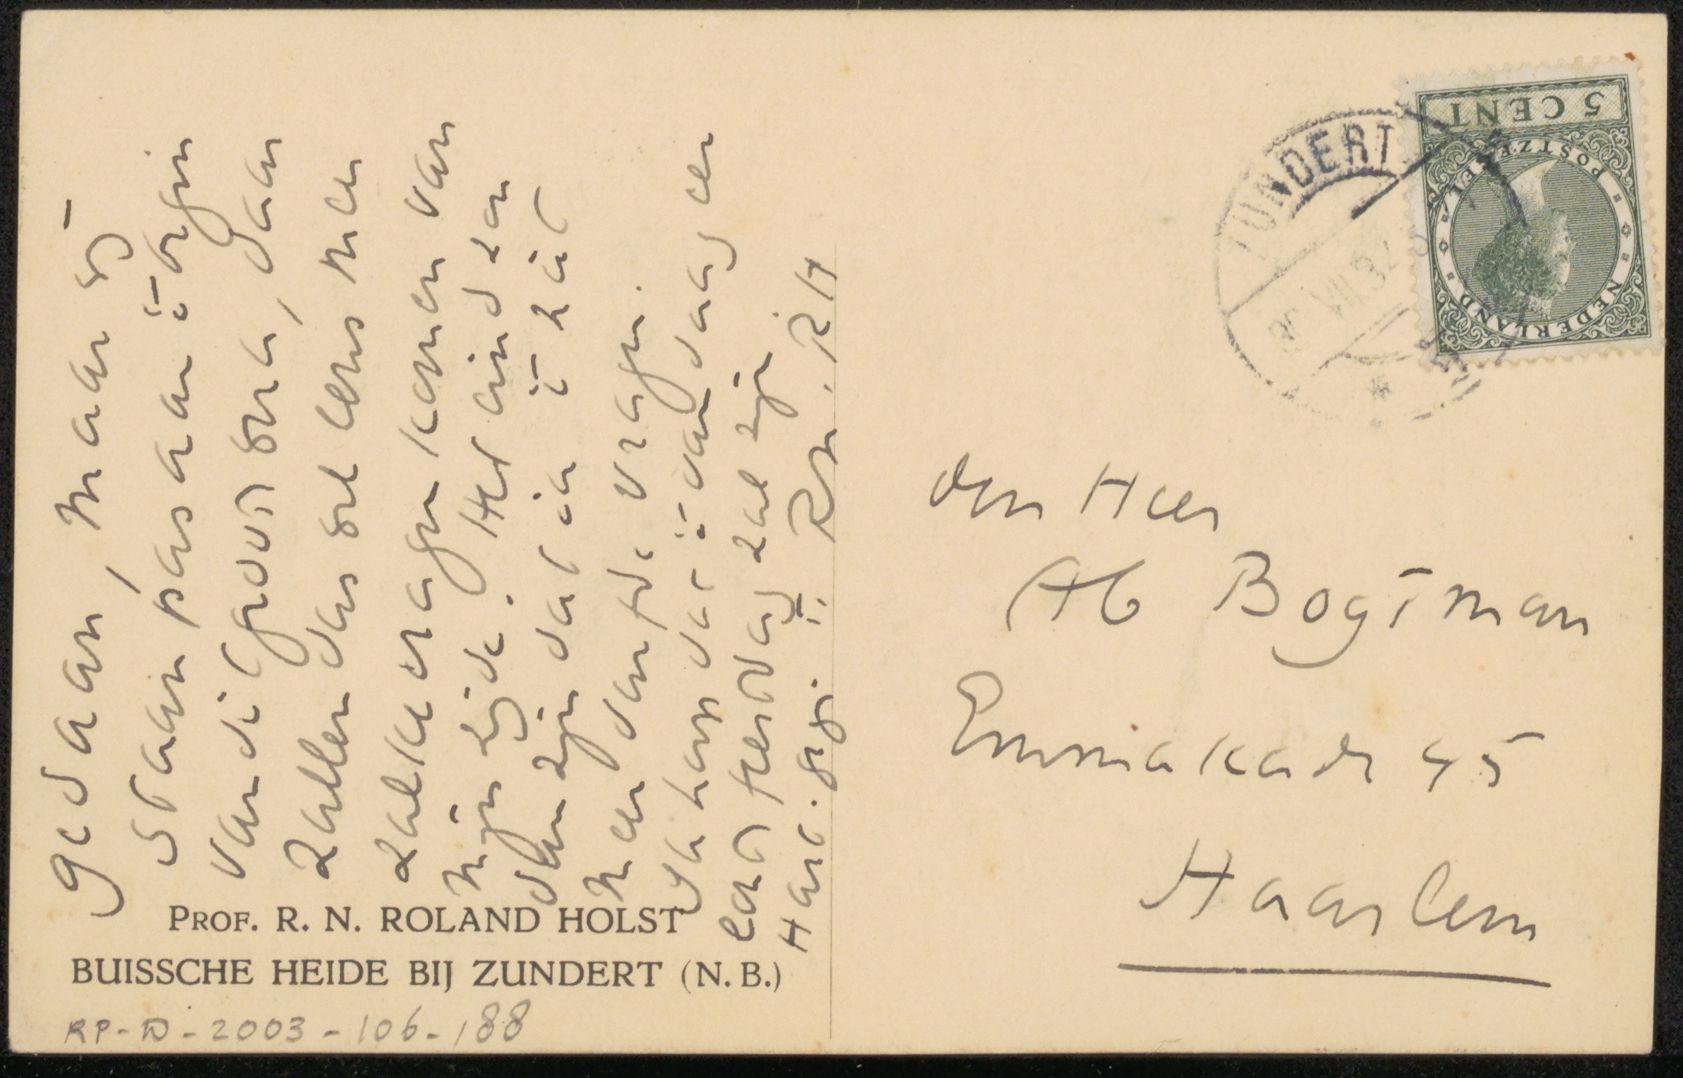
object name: letter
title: Brief aan Ab Bogtman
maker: richard nicolaüs roland holst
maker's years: 1868-1938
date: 1934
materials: cardboard, ink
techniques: pen, writing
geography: zundert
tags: ab bogtman, photography, cinematography